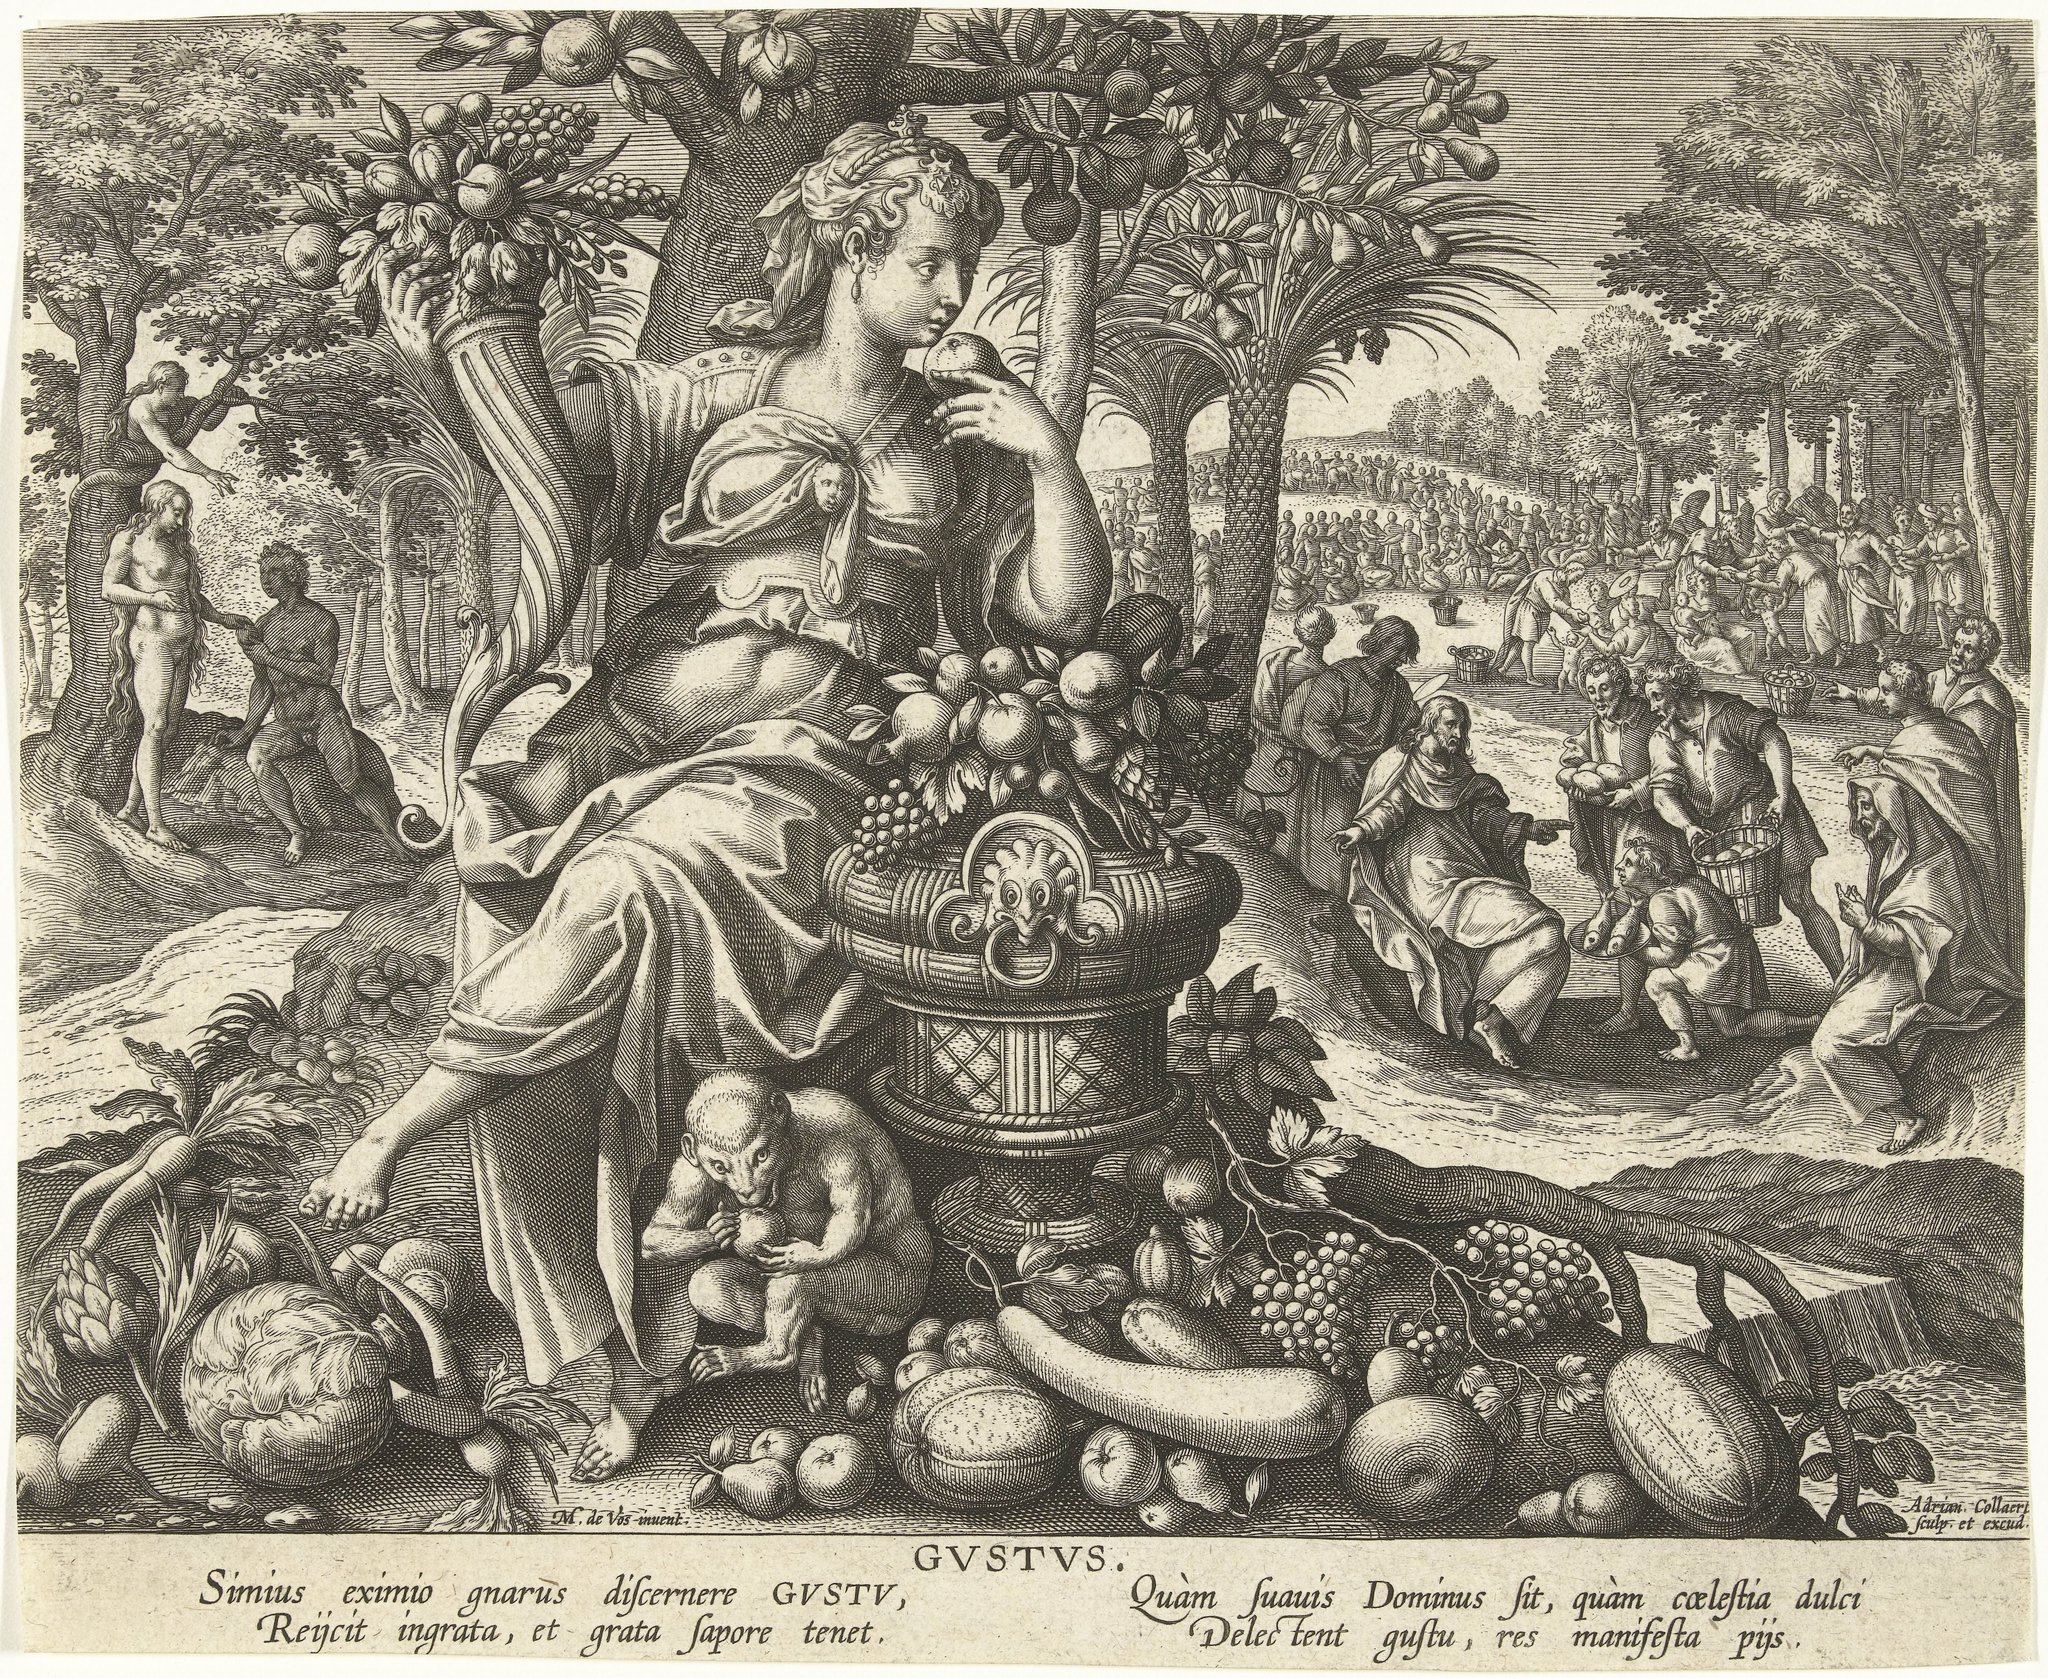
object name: print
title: Smaak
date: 1570-1618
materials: paper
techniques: engraving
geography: antwerp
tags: eve offers the fruit to adam, multiplication of loaves and fishes for a multitude of four or five thousand people (matthew 14:13-21, 15:32-39; mark 6:32-44, 8:1-10; luke 9:10-17; john 6:1-14), taste, tasting (one of the five senses) - aa - female human figure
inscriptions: collector's mark: Lugt 2228, collector's mark: Lugt 2760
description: De allegorische figuur van de smaak. Ze heeft een appel in de hand en een cornucopia. Ze is vergezeld door een aap. Op de achtergrond twee Bijbelscènes: de wonderbare spijziging (Johannes 6:1-14) en Adam en Eva die eten van de boom der kennis van goed en kwaad (Genesis 3:1-6). De prent heeft een Latijns onderschrift en is deel van een vijfdelige serie over de zintuigen.